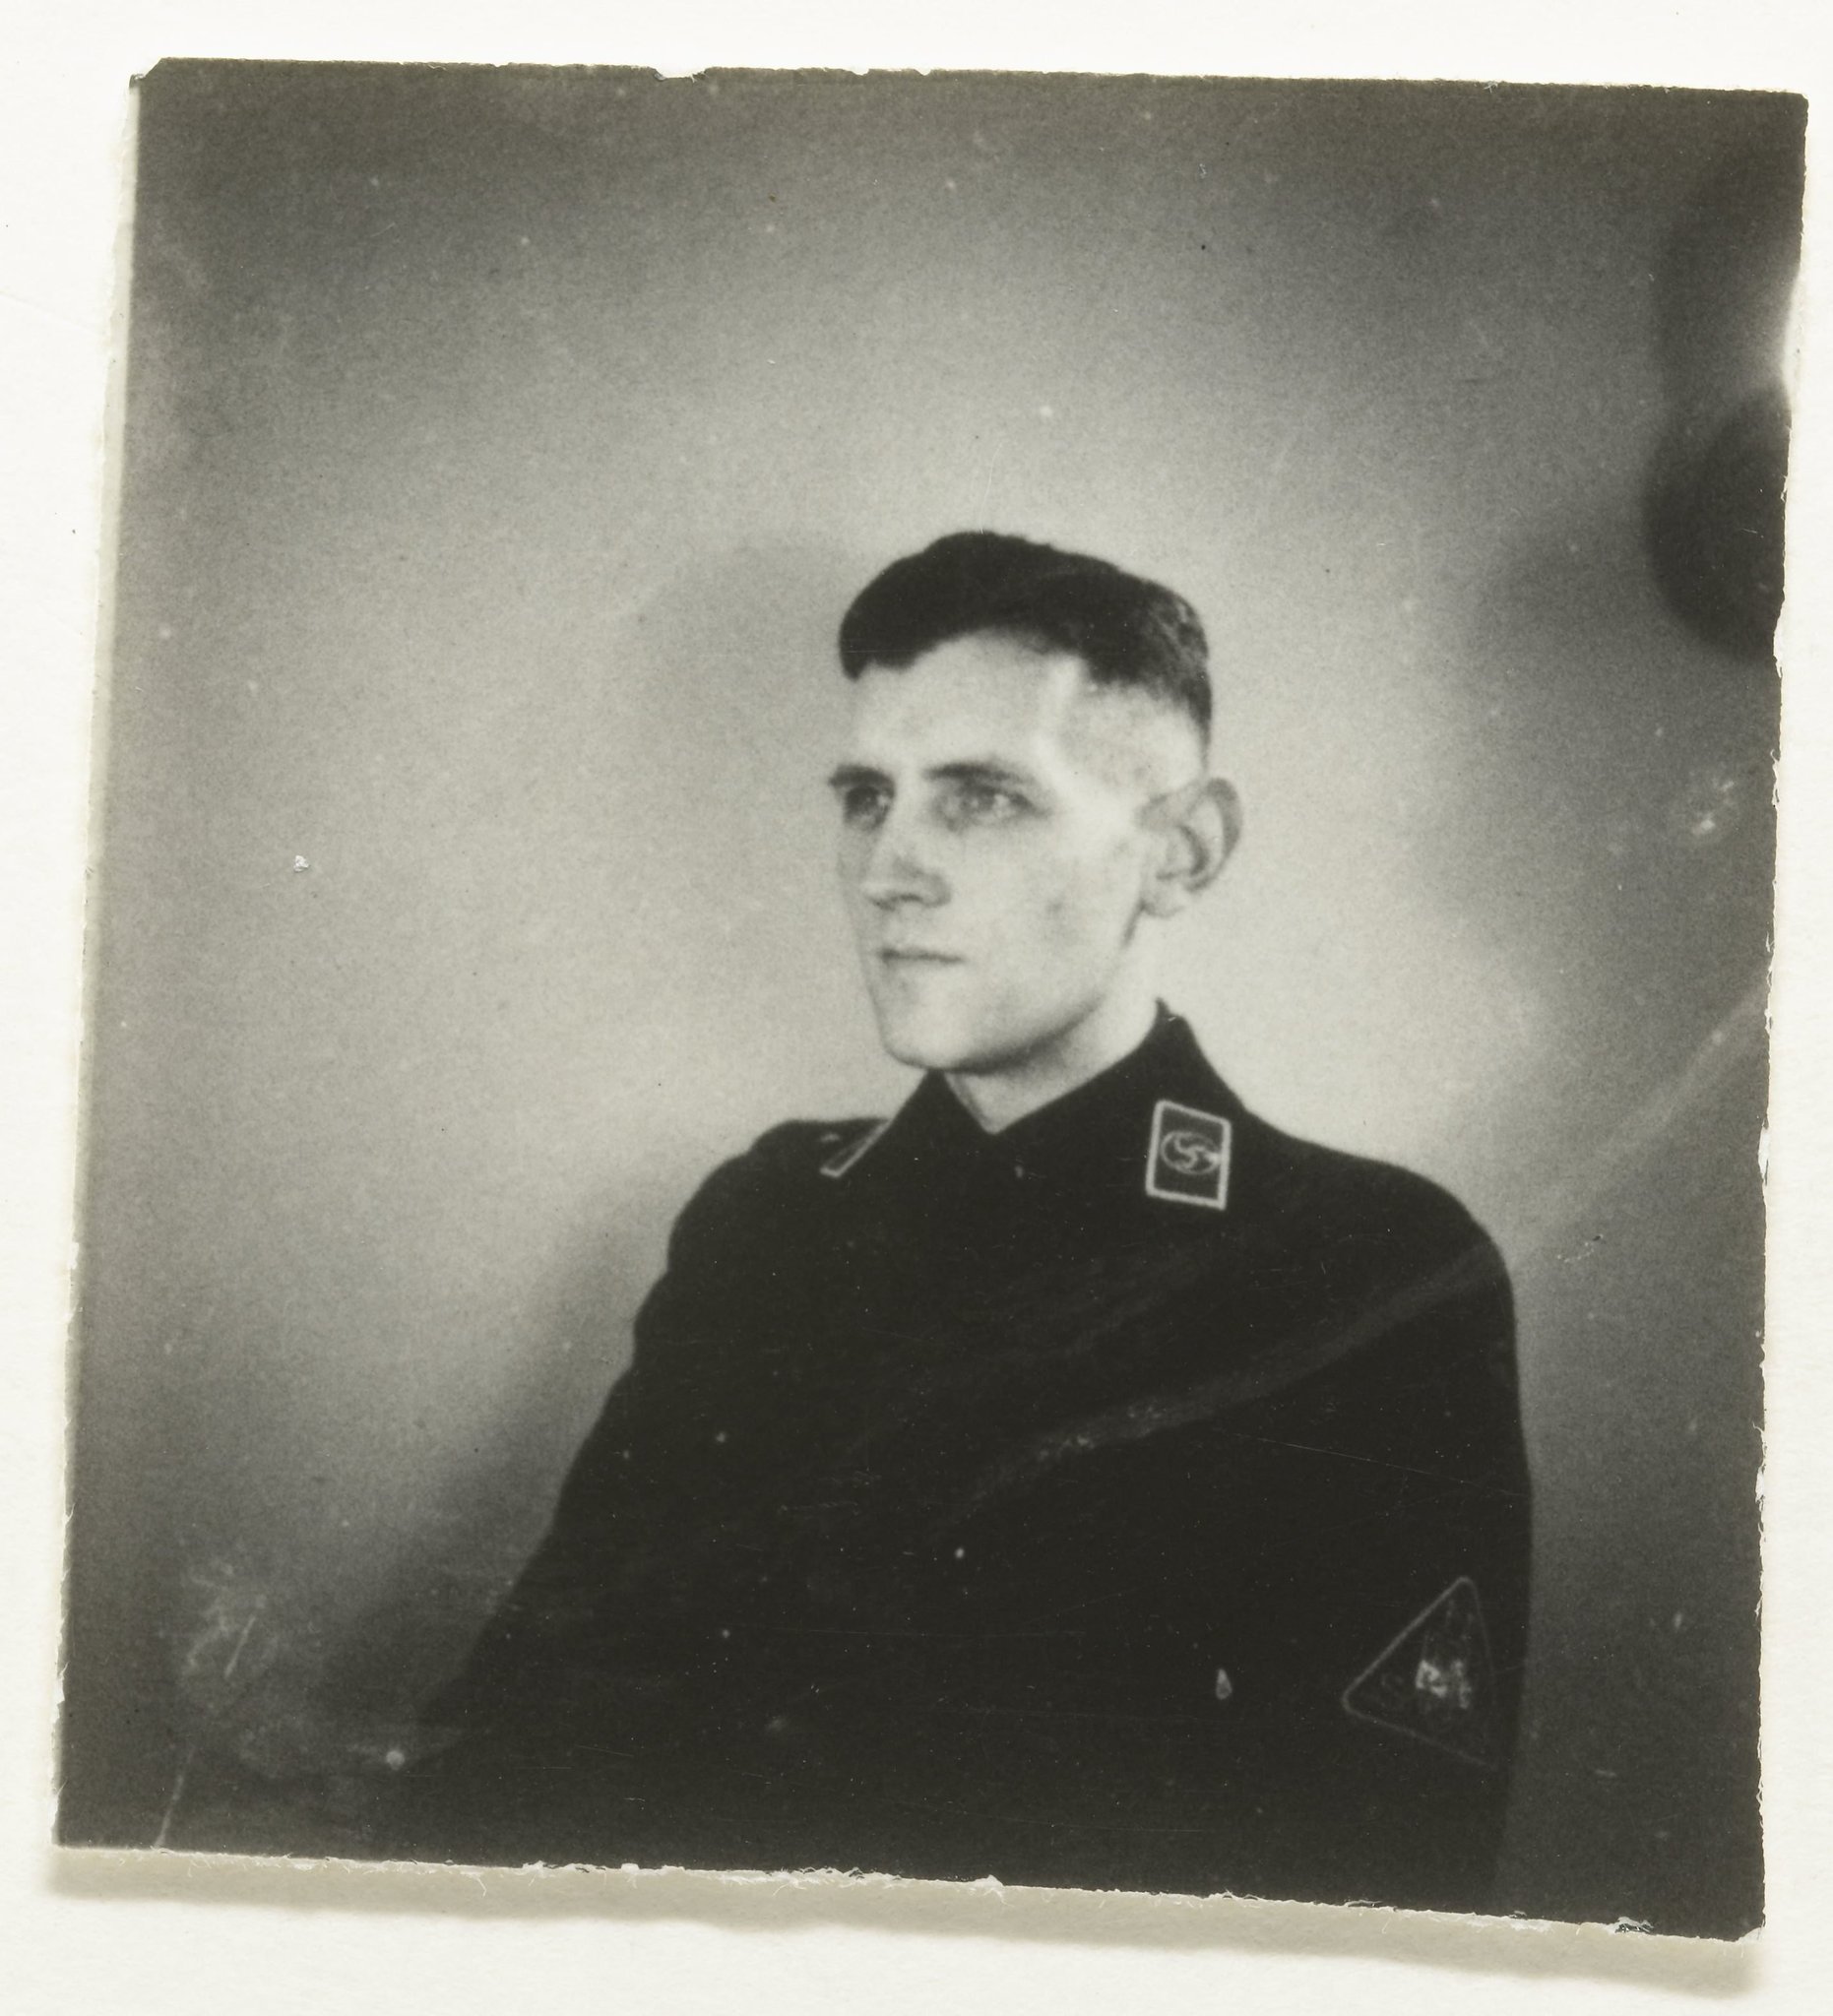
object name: contact print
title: Portret van een lid van de NSB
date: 1940-1944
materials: photographic support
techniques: gelatin silver print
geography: netherlands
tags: anonymous historical person portrayed, netherlands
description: Portret van een lid van de NSB. Op zijn kraag een distinctief met een wentelend zonnerad: plaatsvervangend Sectieleider Fronten en Gilden. Op zijn linkermouw het driehoekig embleem van de NSB. Blootshoofd.